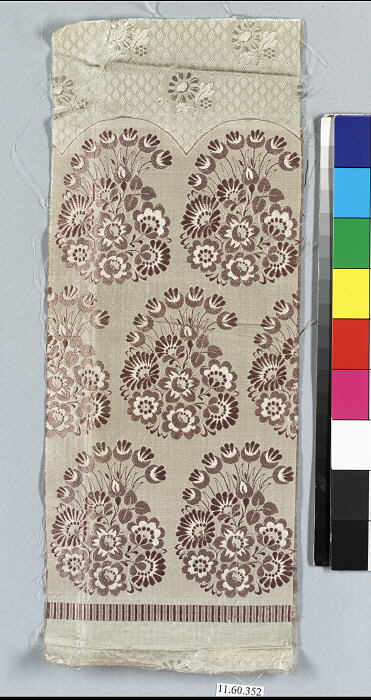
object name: fragment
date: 1801-1900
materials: silk